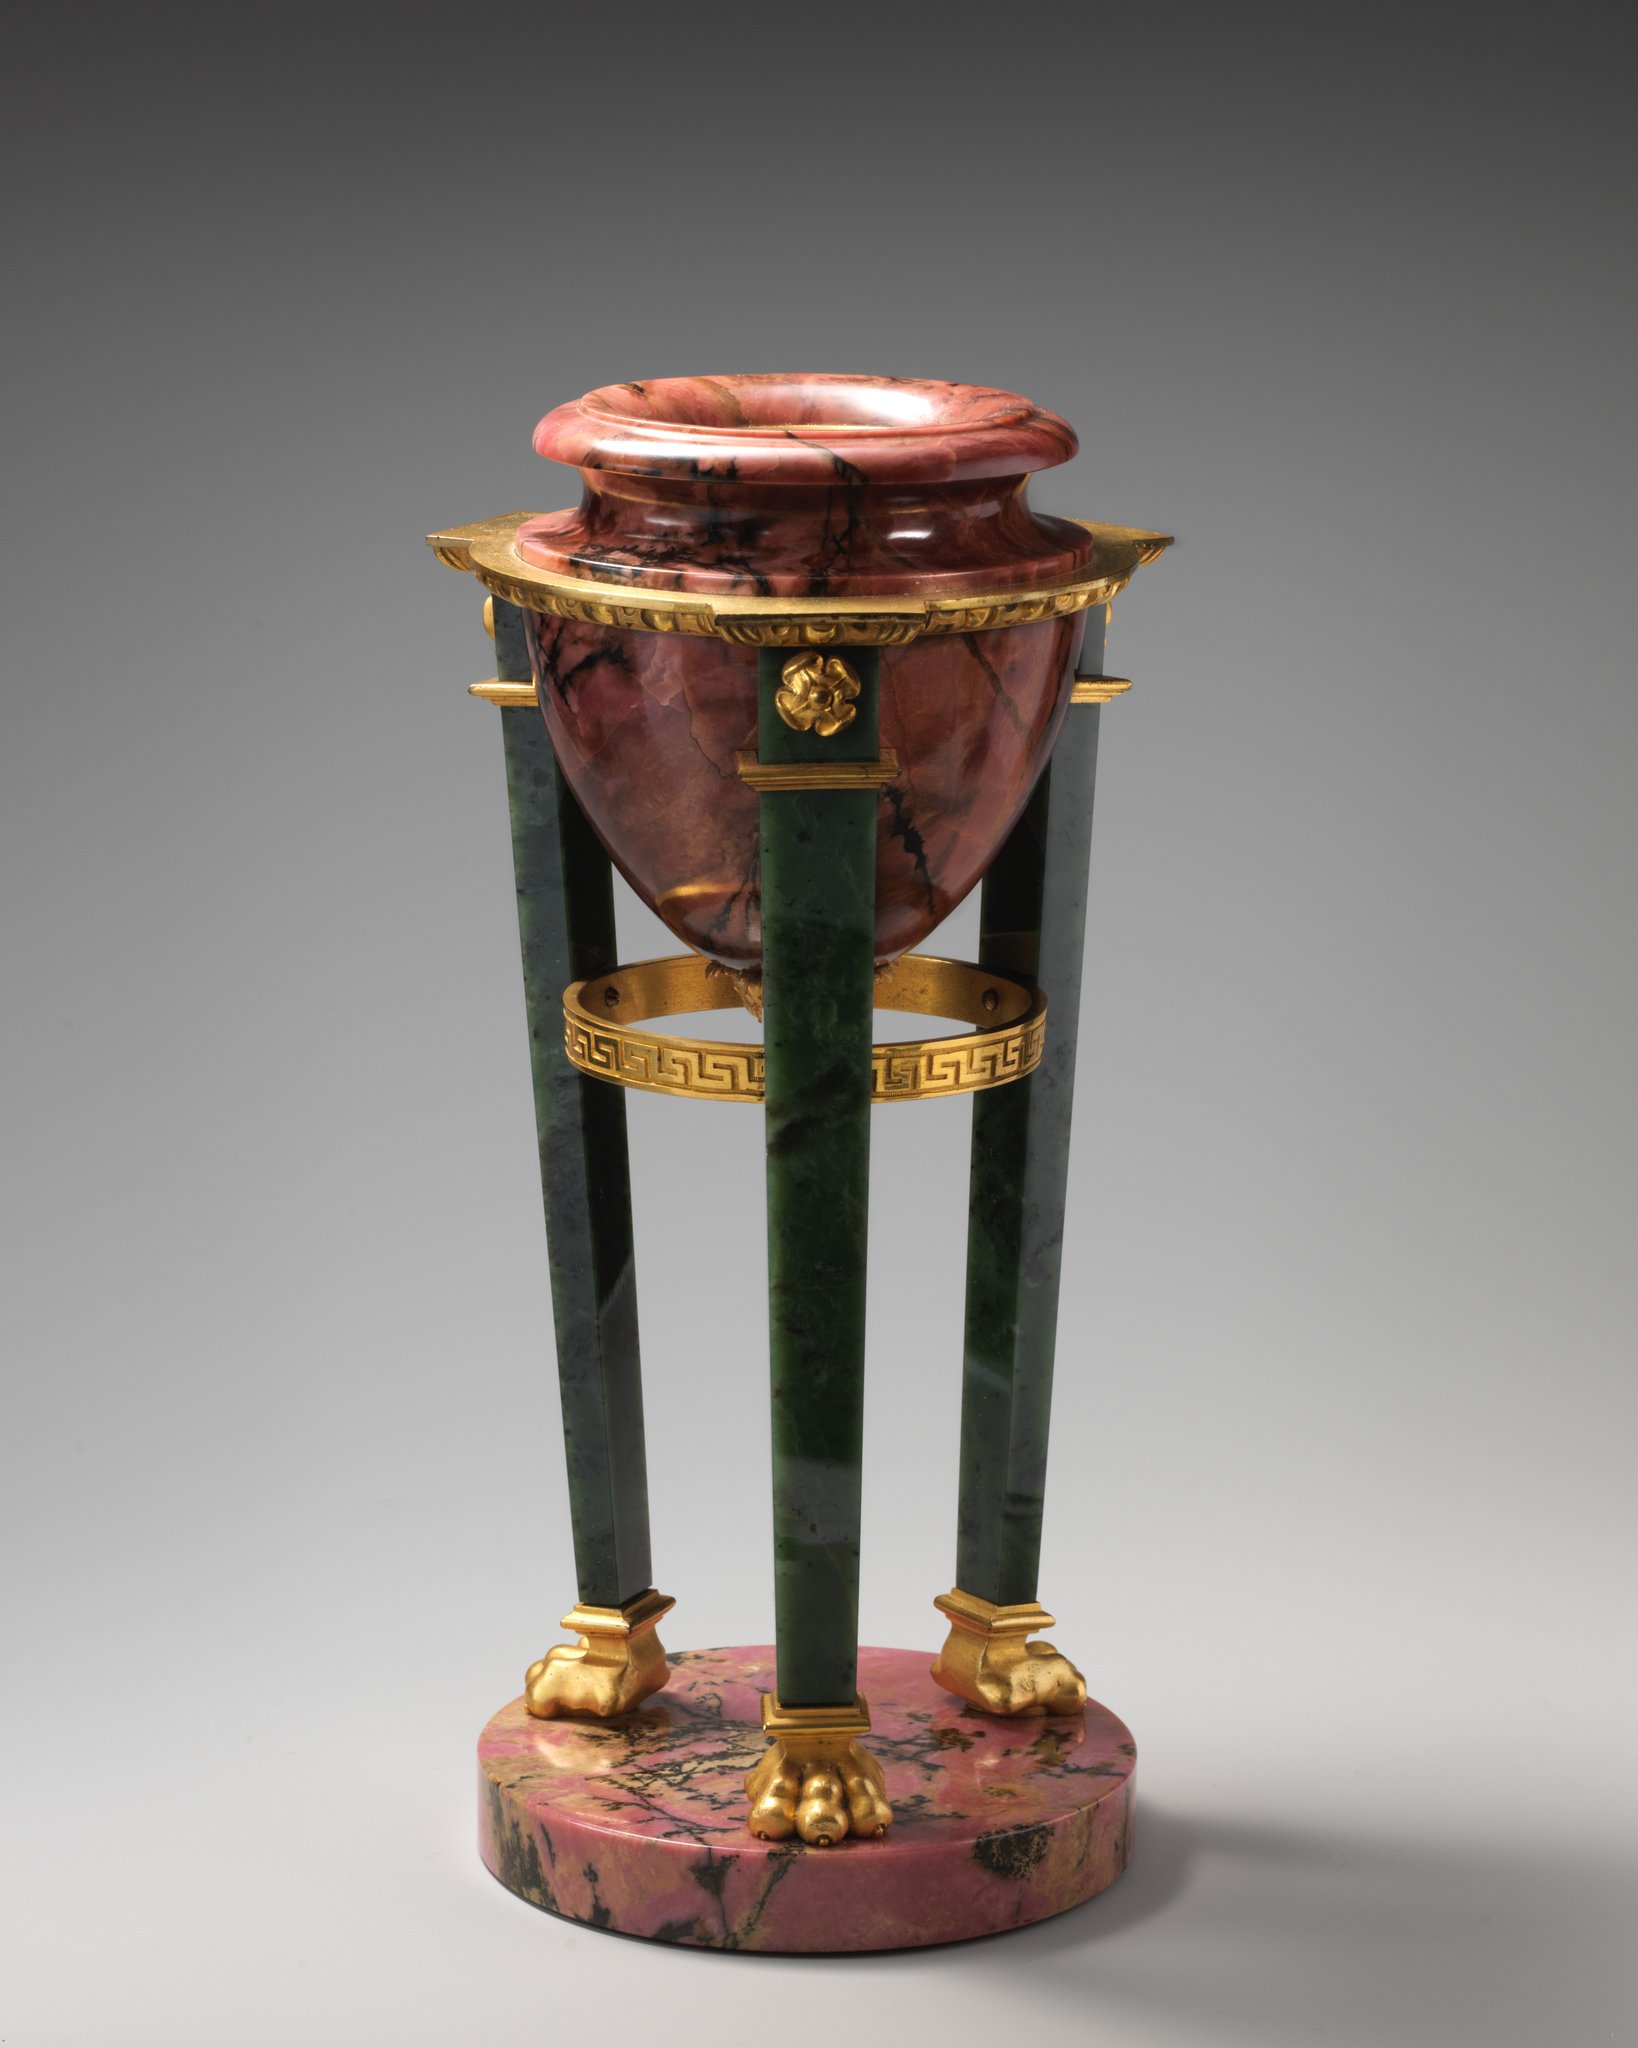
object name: tripod stand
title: Small Tripod Stand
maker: imperial lapidary manufactory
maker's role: maker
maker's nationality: russian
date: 1840-1850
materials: gilt bronze, jade